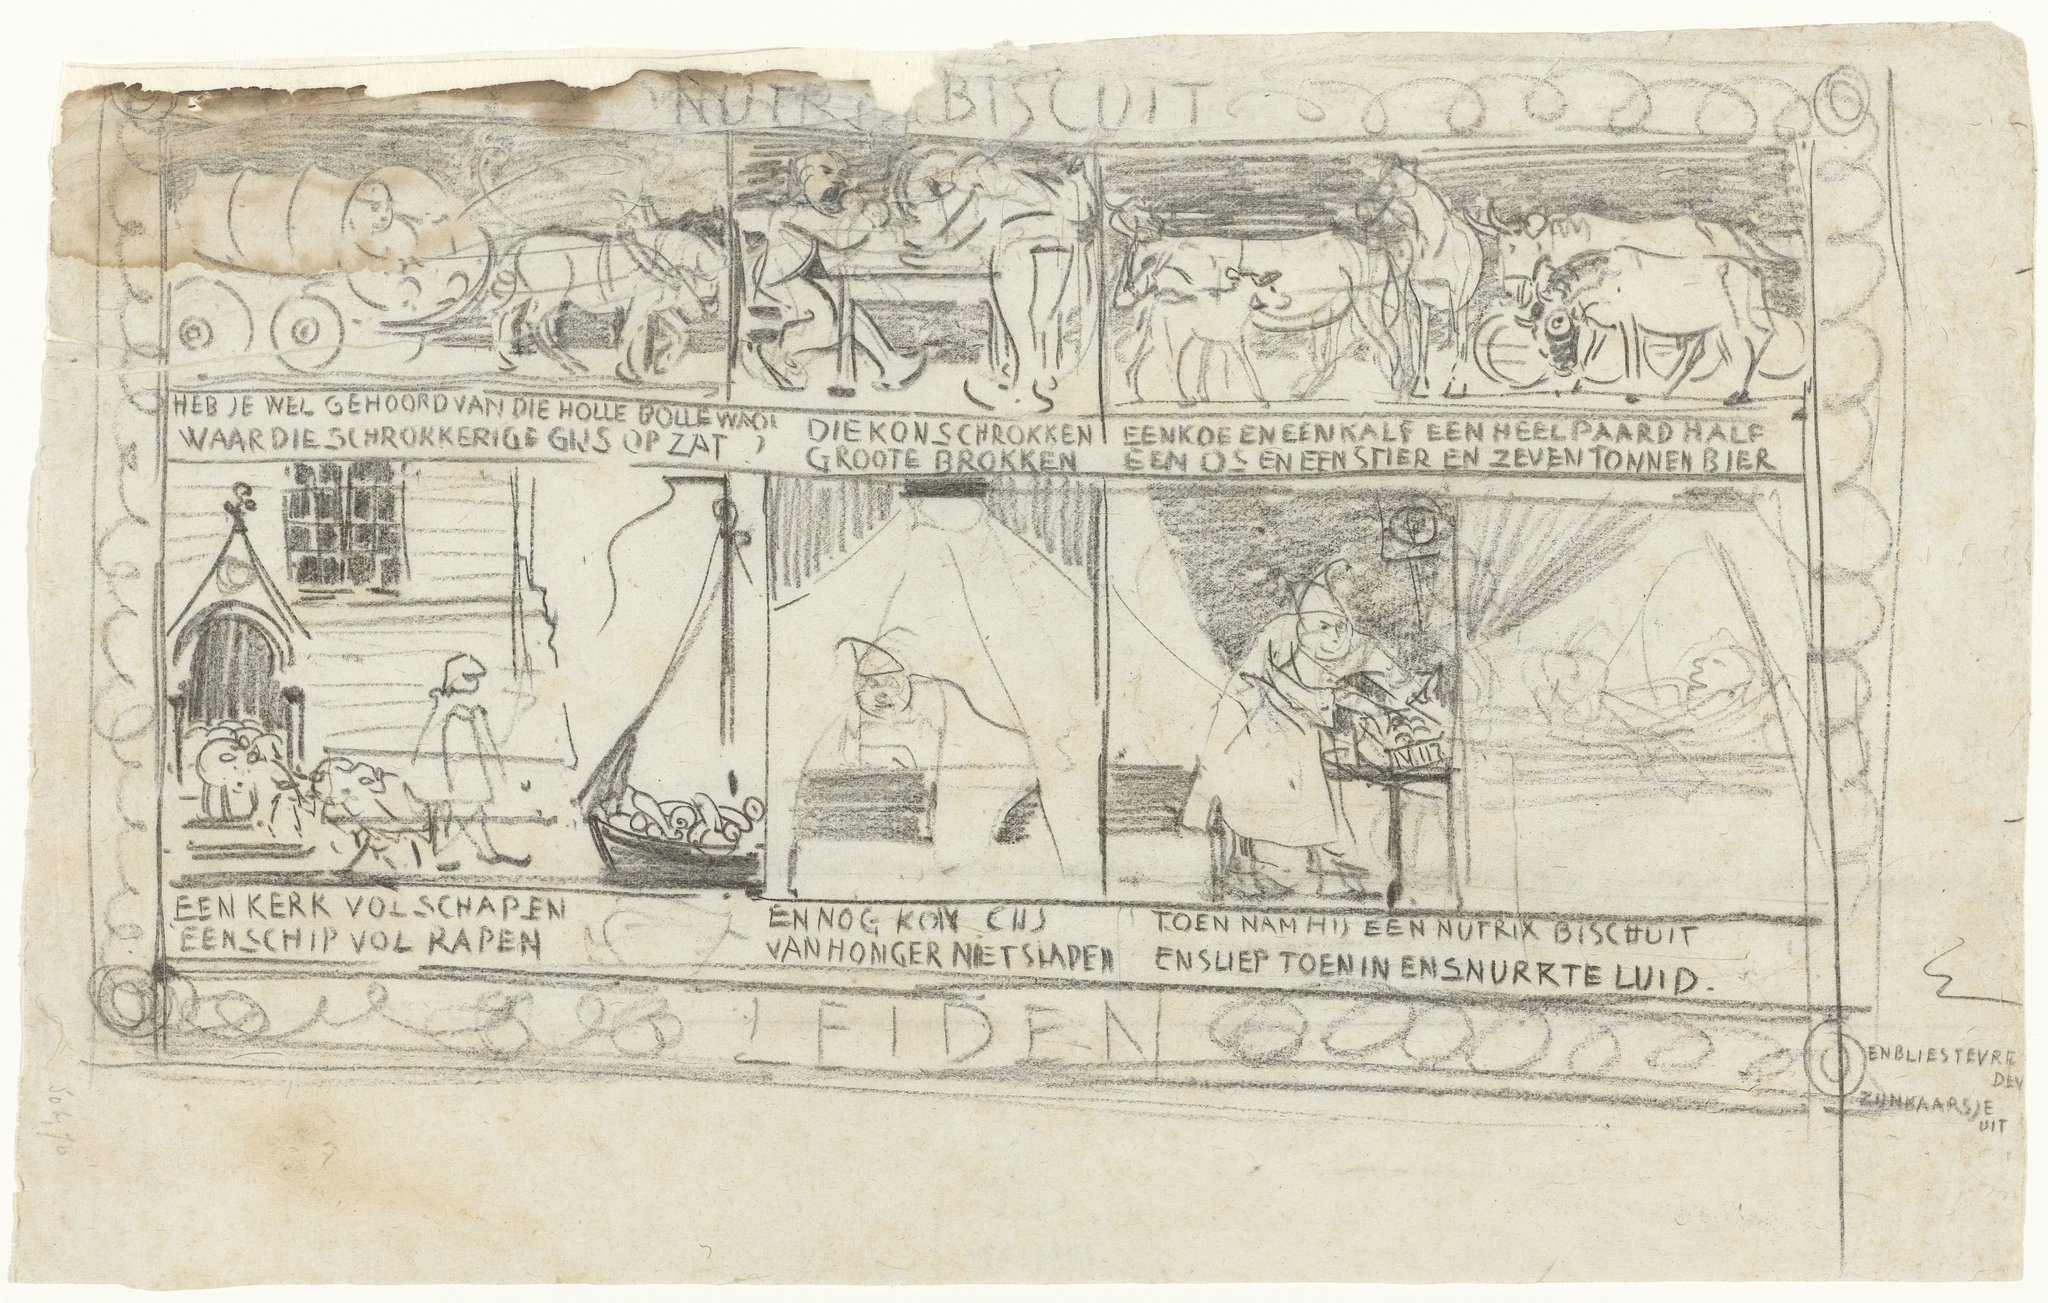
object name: drawing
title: Ontwerp voor reclame van Nutrix beschuit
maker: gerrit willem dijsselhof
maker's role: designer, draughtsman, print maker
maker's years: 1866-1924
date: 1876-1924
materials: chalk, paper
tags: advertising, (other) historical names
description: Ontwerp voor reclame van Nutrix beschuit 'De holle bolle wagen'.